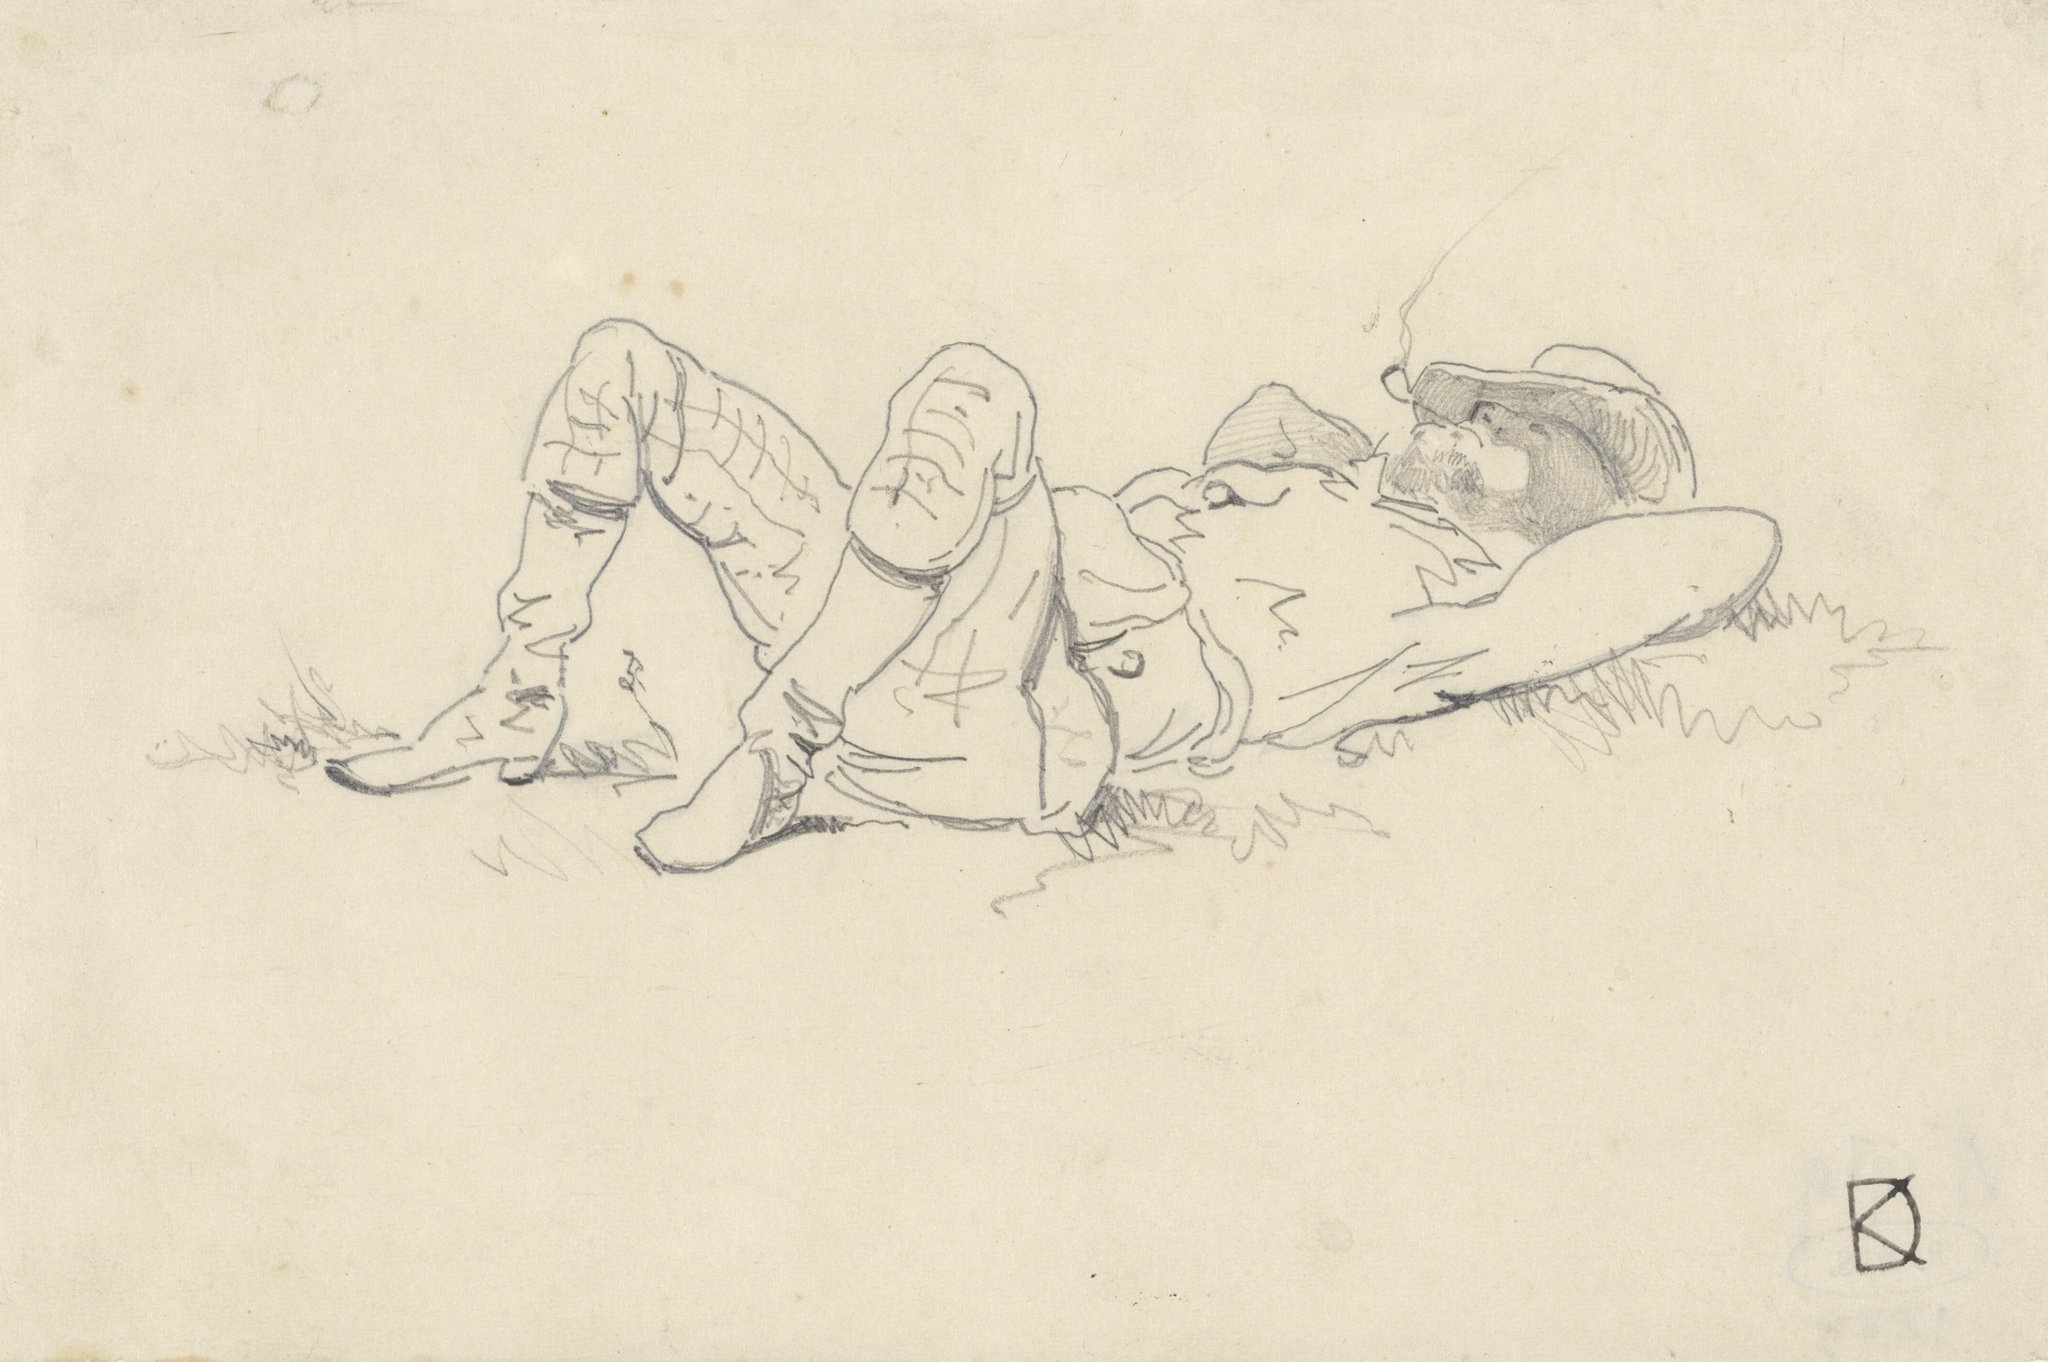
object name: drawing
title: Man achterover liggend in het gras met de benen opgetrokken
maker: johan daniël koelman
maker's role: draughtsman, print maker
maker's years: 1831-1857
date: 1841-1857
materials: paper, pencil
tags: lying figure